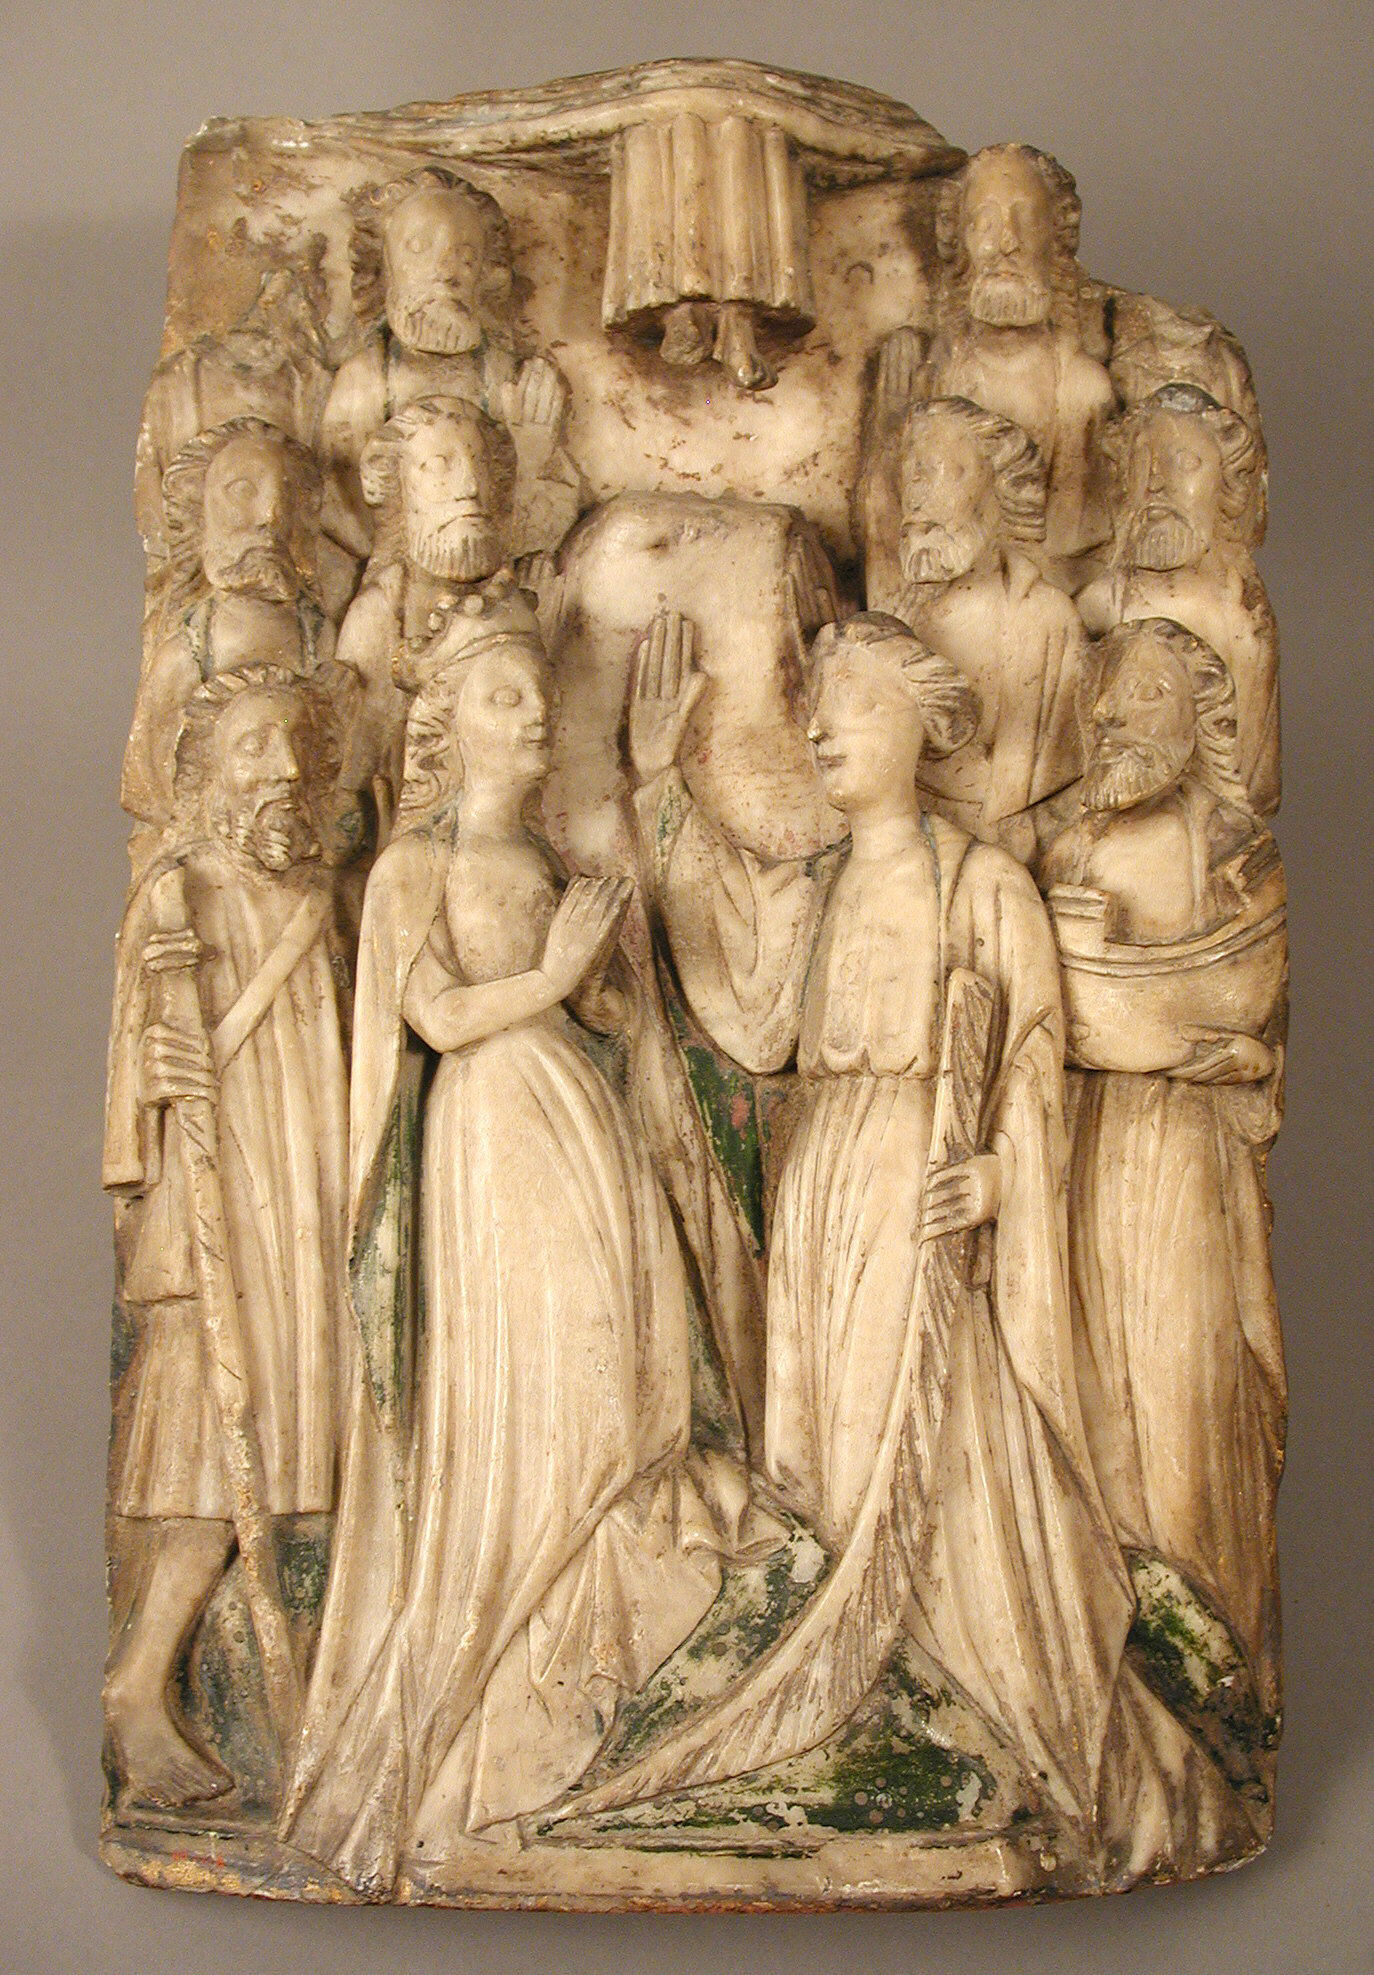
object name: panel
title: The Ascension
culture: british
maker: school of nottingham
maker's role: artist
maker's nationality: british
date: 1401-1500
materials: alabaster, paint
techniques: gilding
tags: women